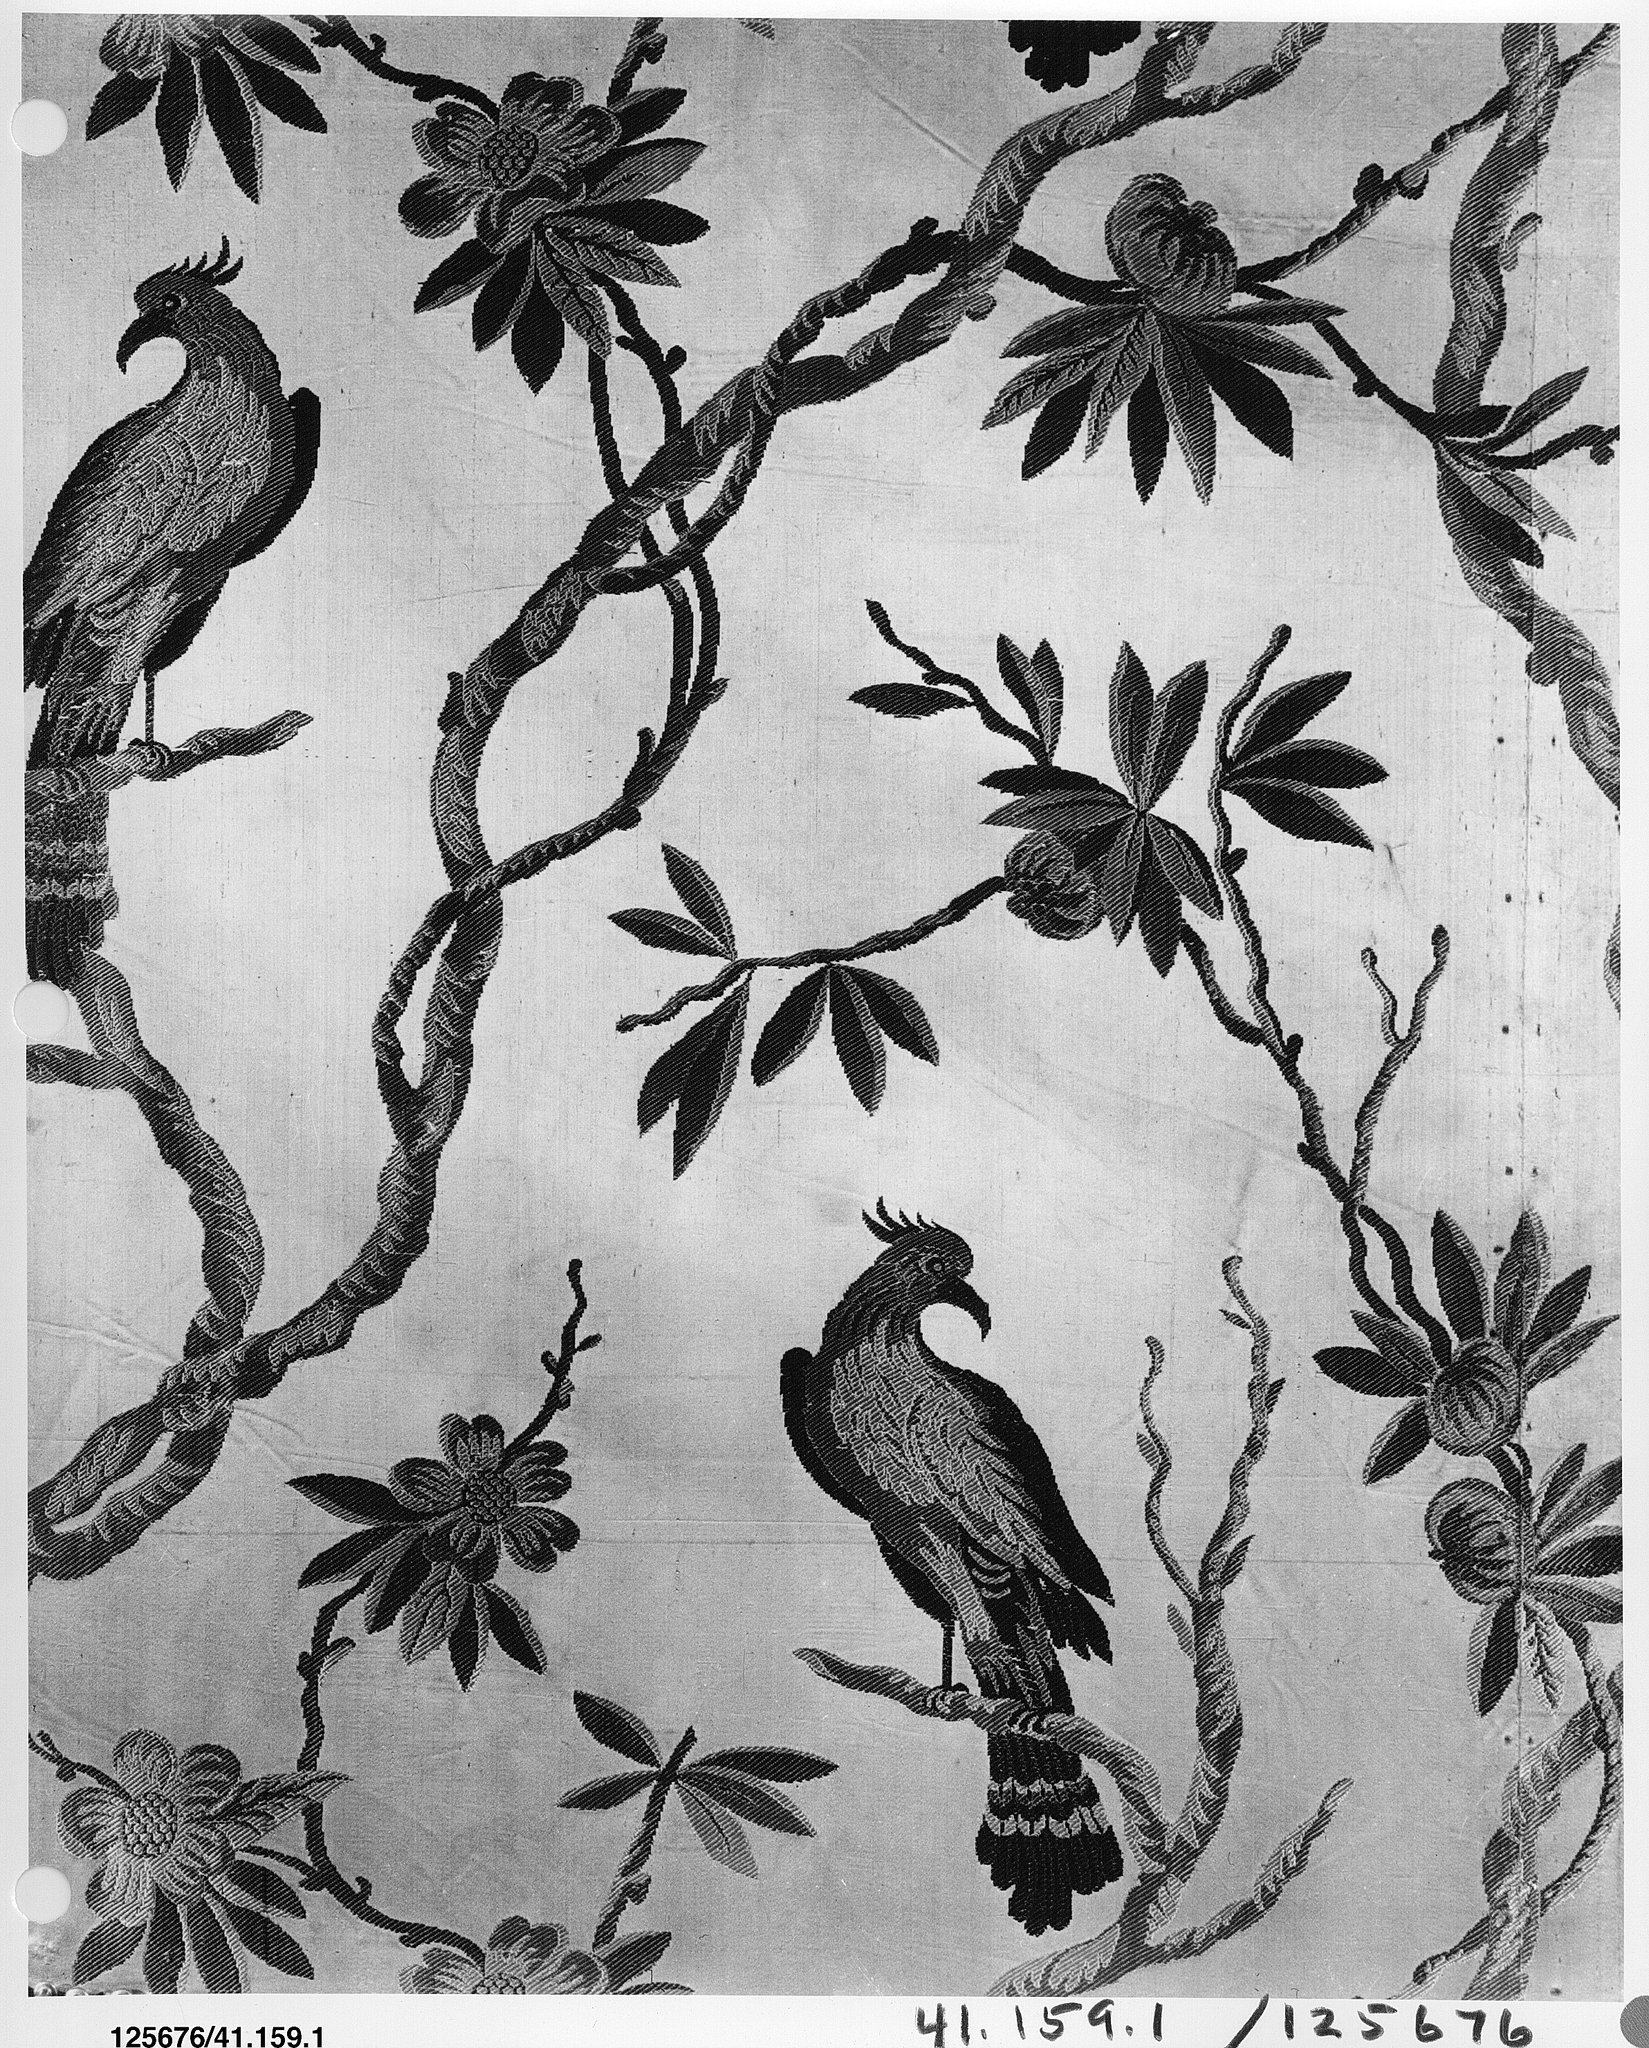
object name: piece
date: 1701-1800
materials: silk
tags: birds,flowers,trees